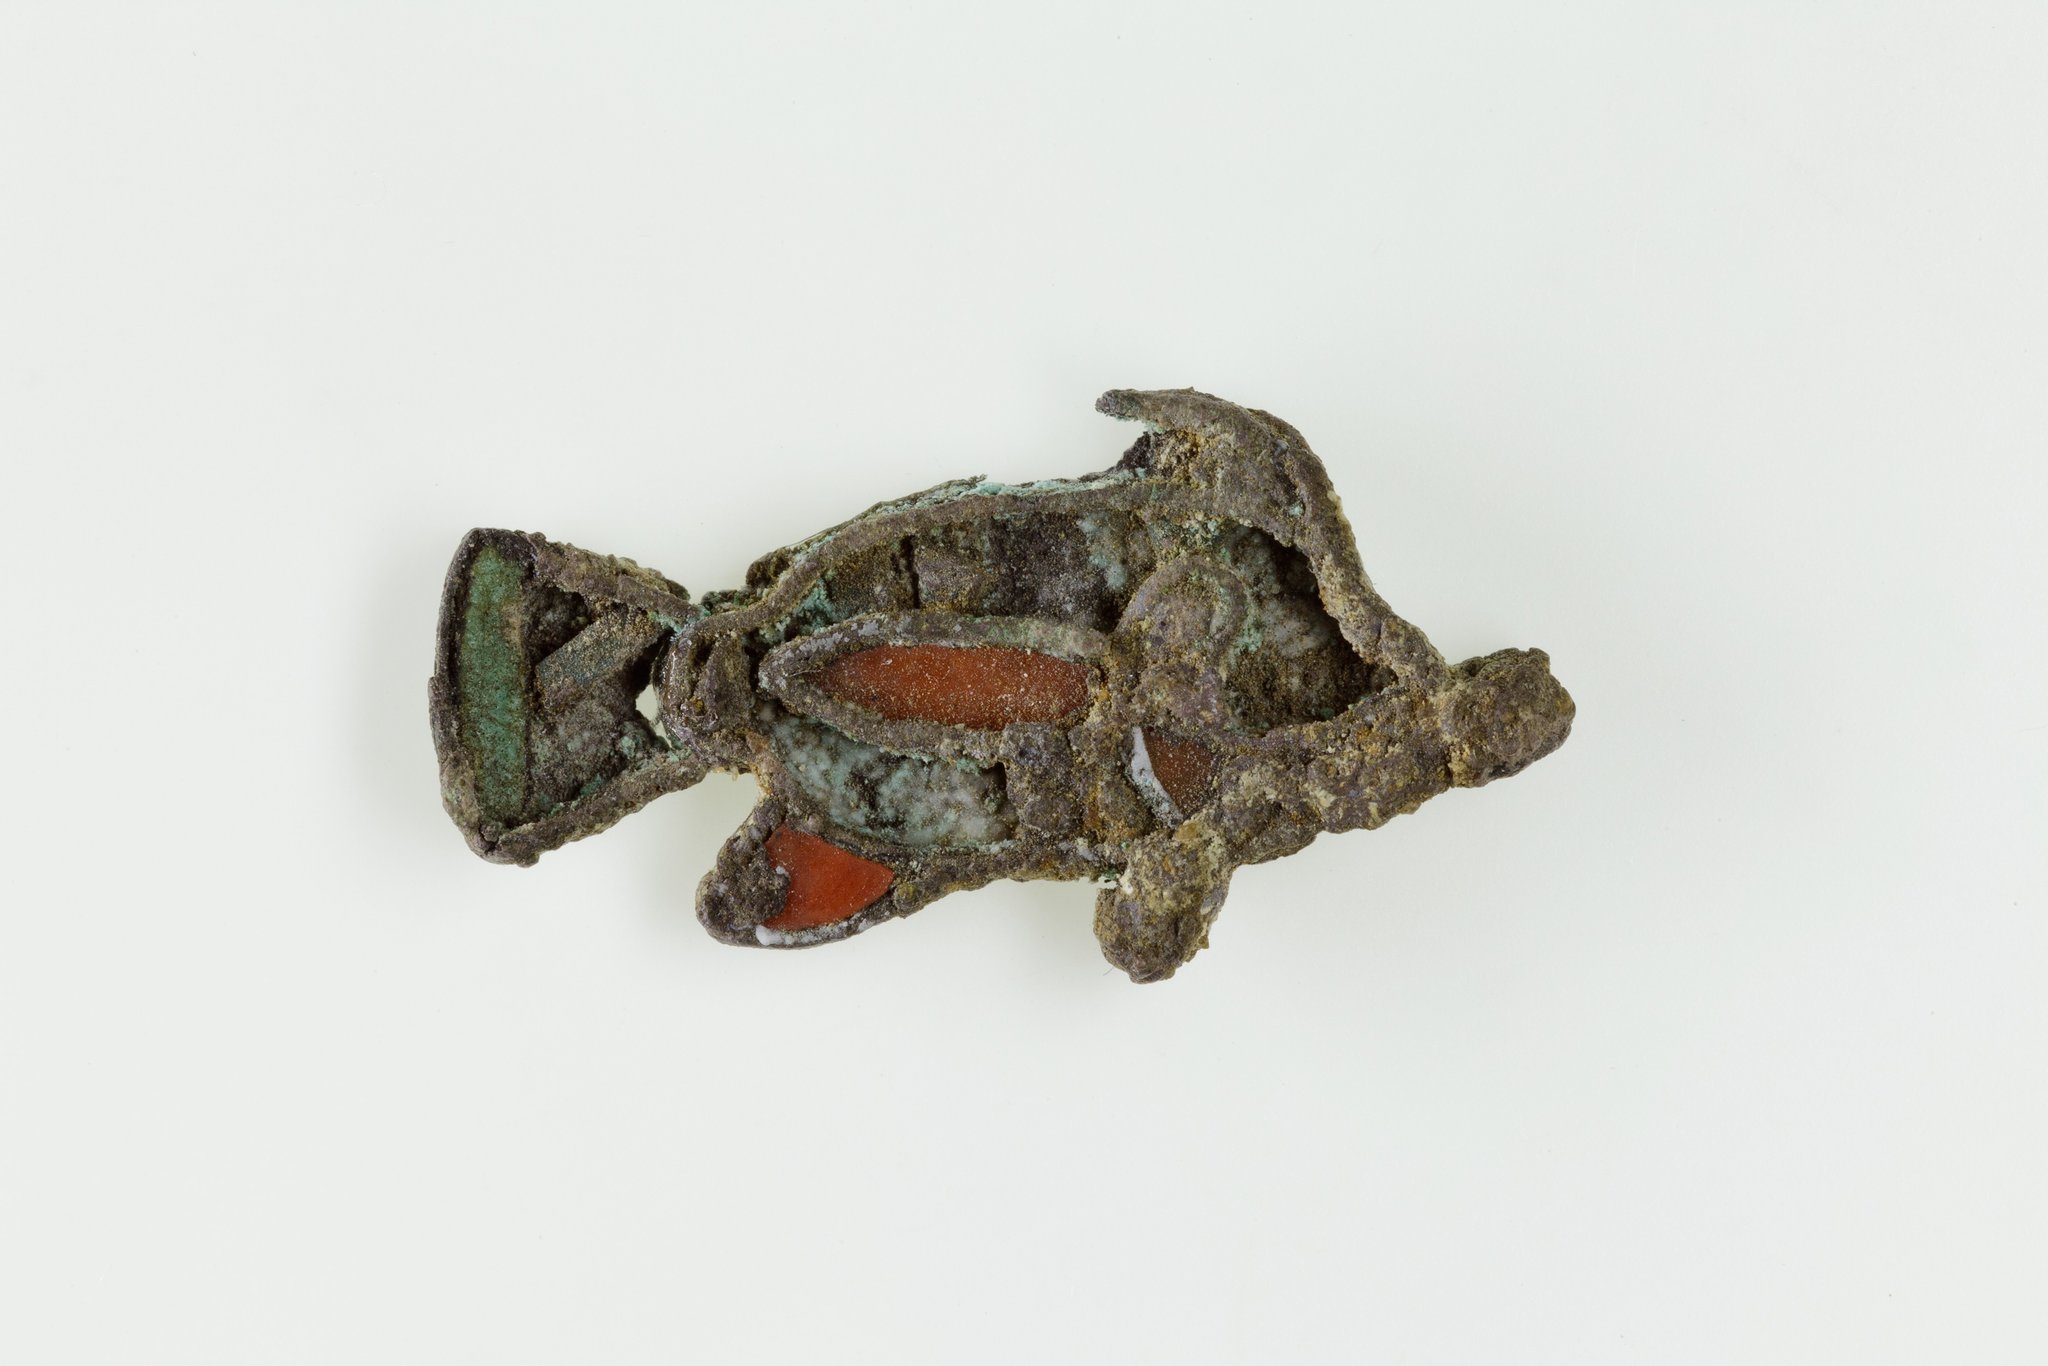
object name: amulet, fish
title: Fish amulet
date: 1950-1804 BCE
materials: gemstone, faience, silver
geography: egypt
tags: fish